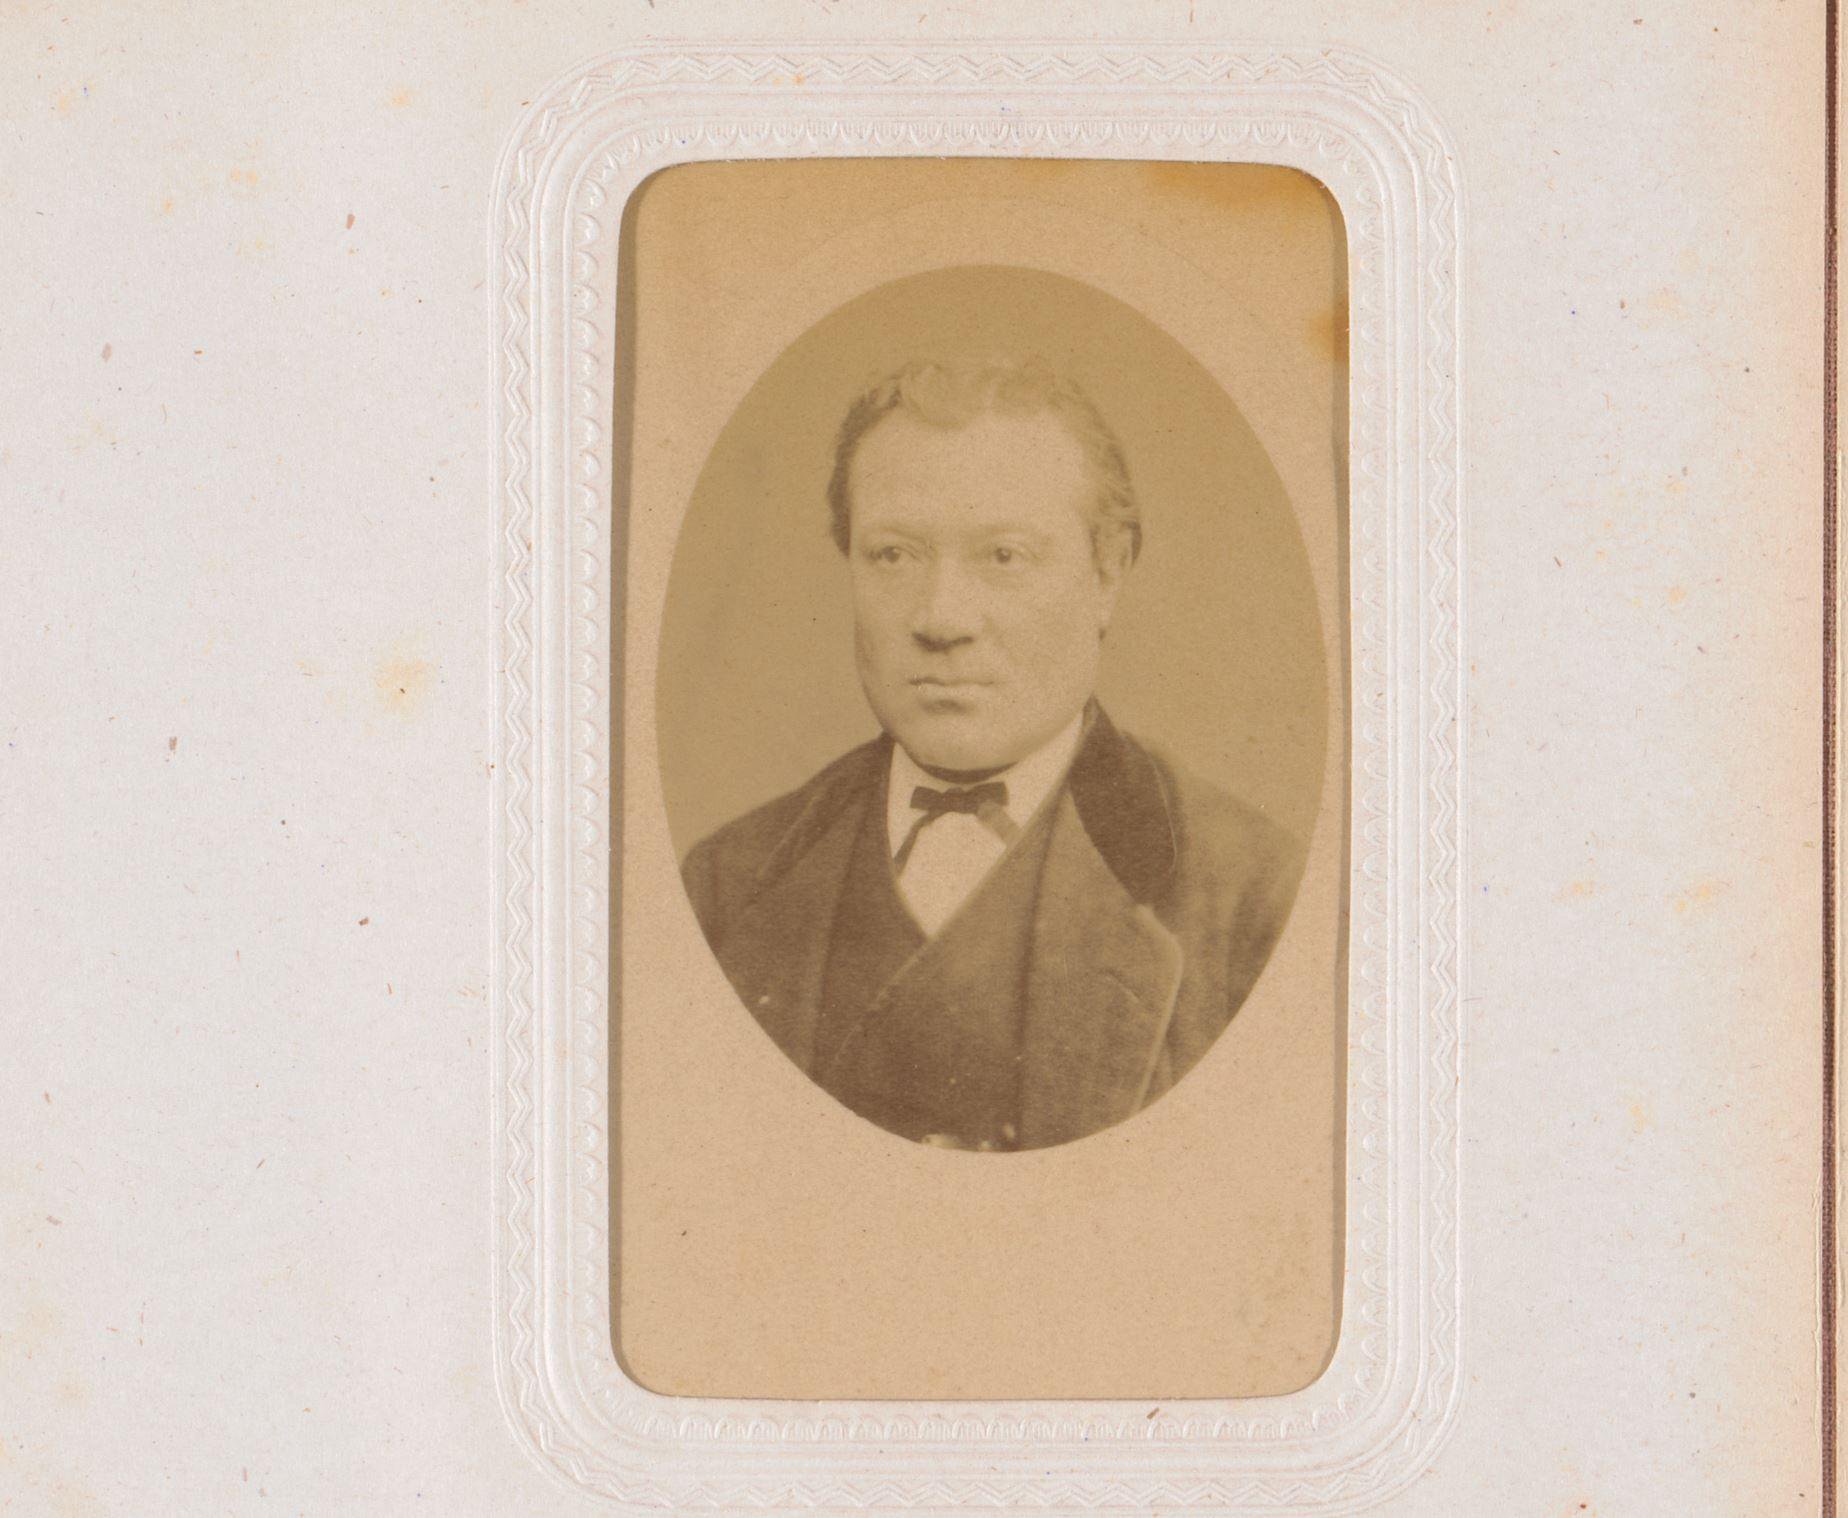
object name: photograph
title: Portret van een man, aangeduid als W. Uithoven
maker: kornelis willem schorteldoek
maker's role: boekbinder, fotograaf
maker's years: 1800-1885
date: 1855-1885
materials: cardboard, photographic support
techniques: albumen print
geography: gorinchem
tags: historical persons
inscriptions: inscription: ‘SCHORTELDOEK/ PHOTOGRAAF/ Gorinchem./ Groote Markt’, name: ‘Uithoven’, name: ‘W. Uithoven’